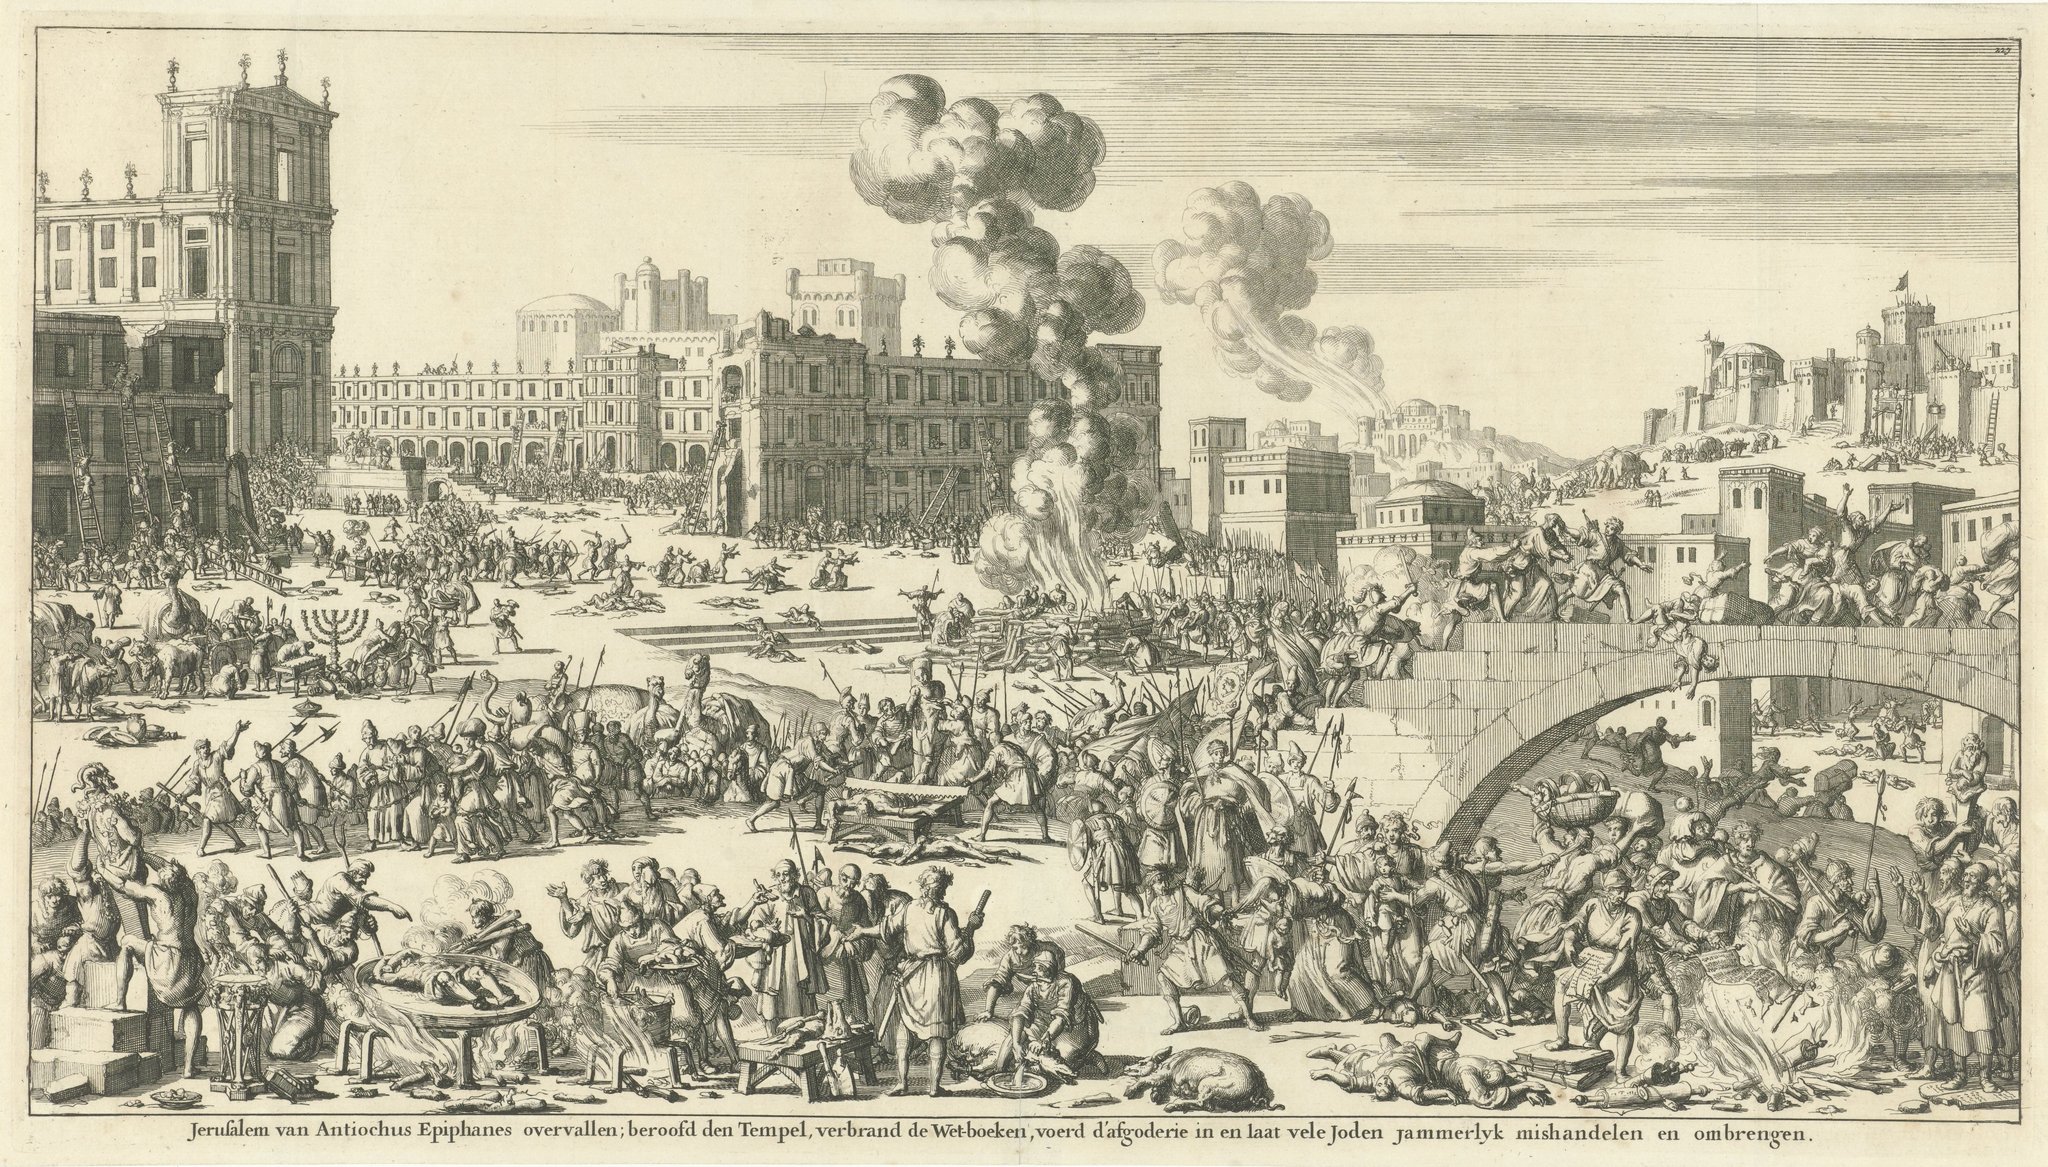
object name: book illustration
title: Jerusalem van Antiochus Epiphanes overvallen; beroofd den Tempel, verbrand de Wet-boeken, voerd d'afgoderie in en laat vele Joden jammerlyk mishandelen en ombrengen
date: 1690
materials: paper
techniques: etching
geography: amsterdam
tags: breaking into city or fortress ~ siege, violent death, being killed; being mishandled and maltreated; seeking death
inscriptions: collector's mark: Lugt 2228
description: Illustratie opgenomen in: Goeree, Wilhelmus. Voor-bereidselen tot de bybelsche wysheid, en gebruik der heilige en kerklijke historien, 3 delen. Amsterdam: Wilhelmus Goeree I, 1690, dl. I.